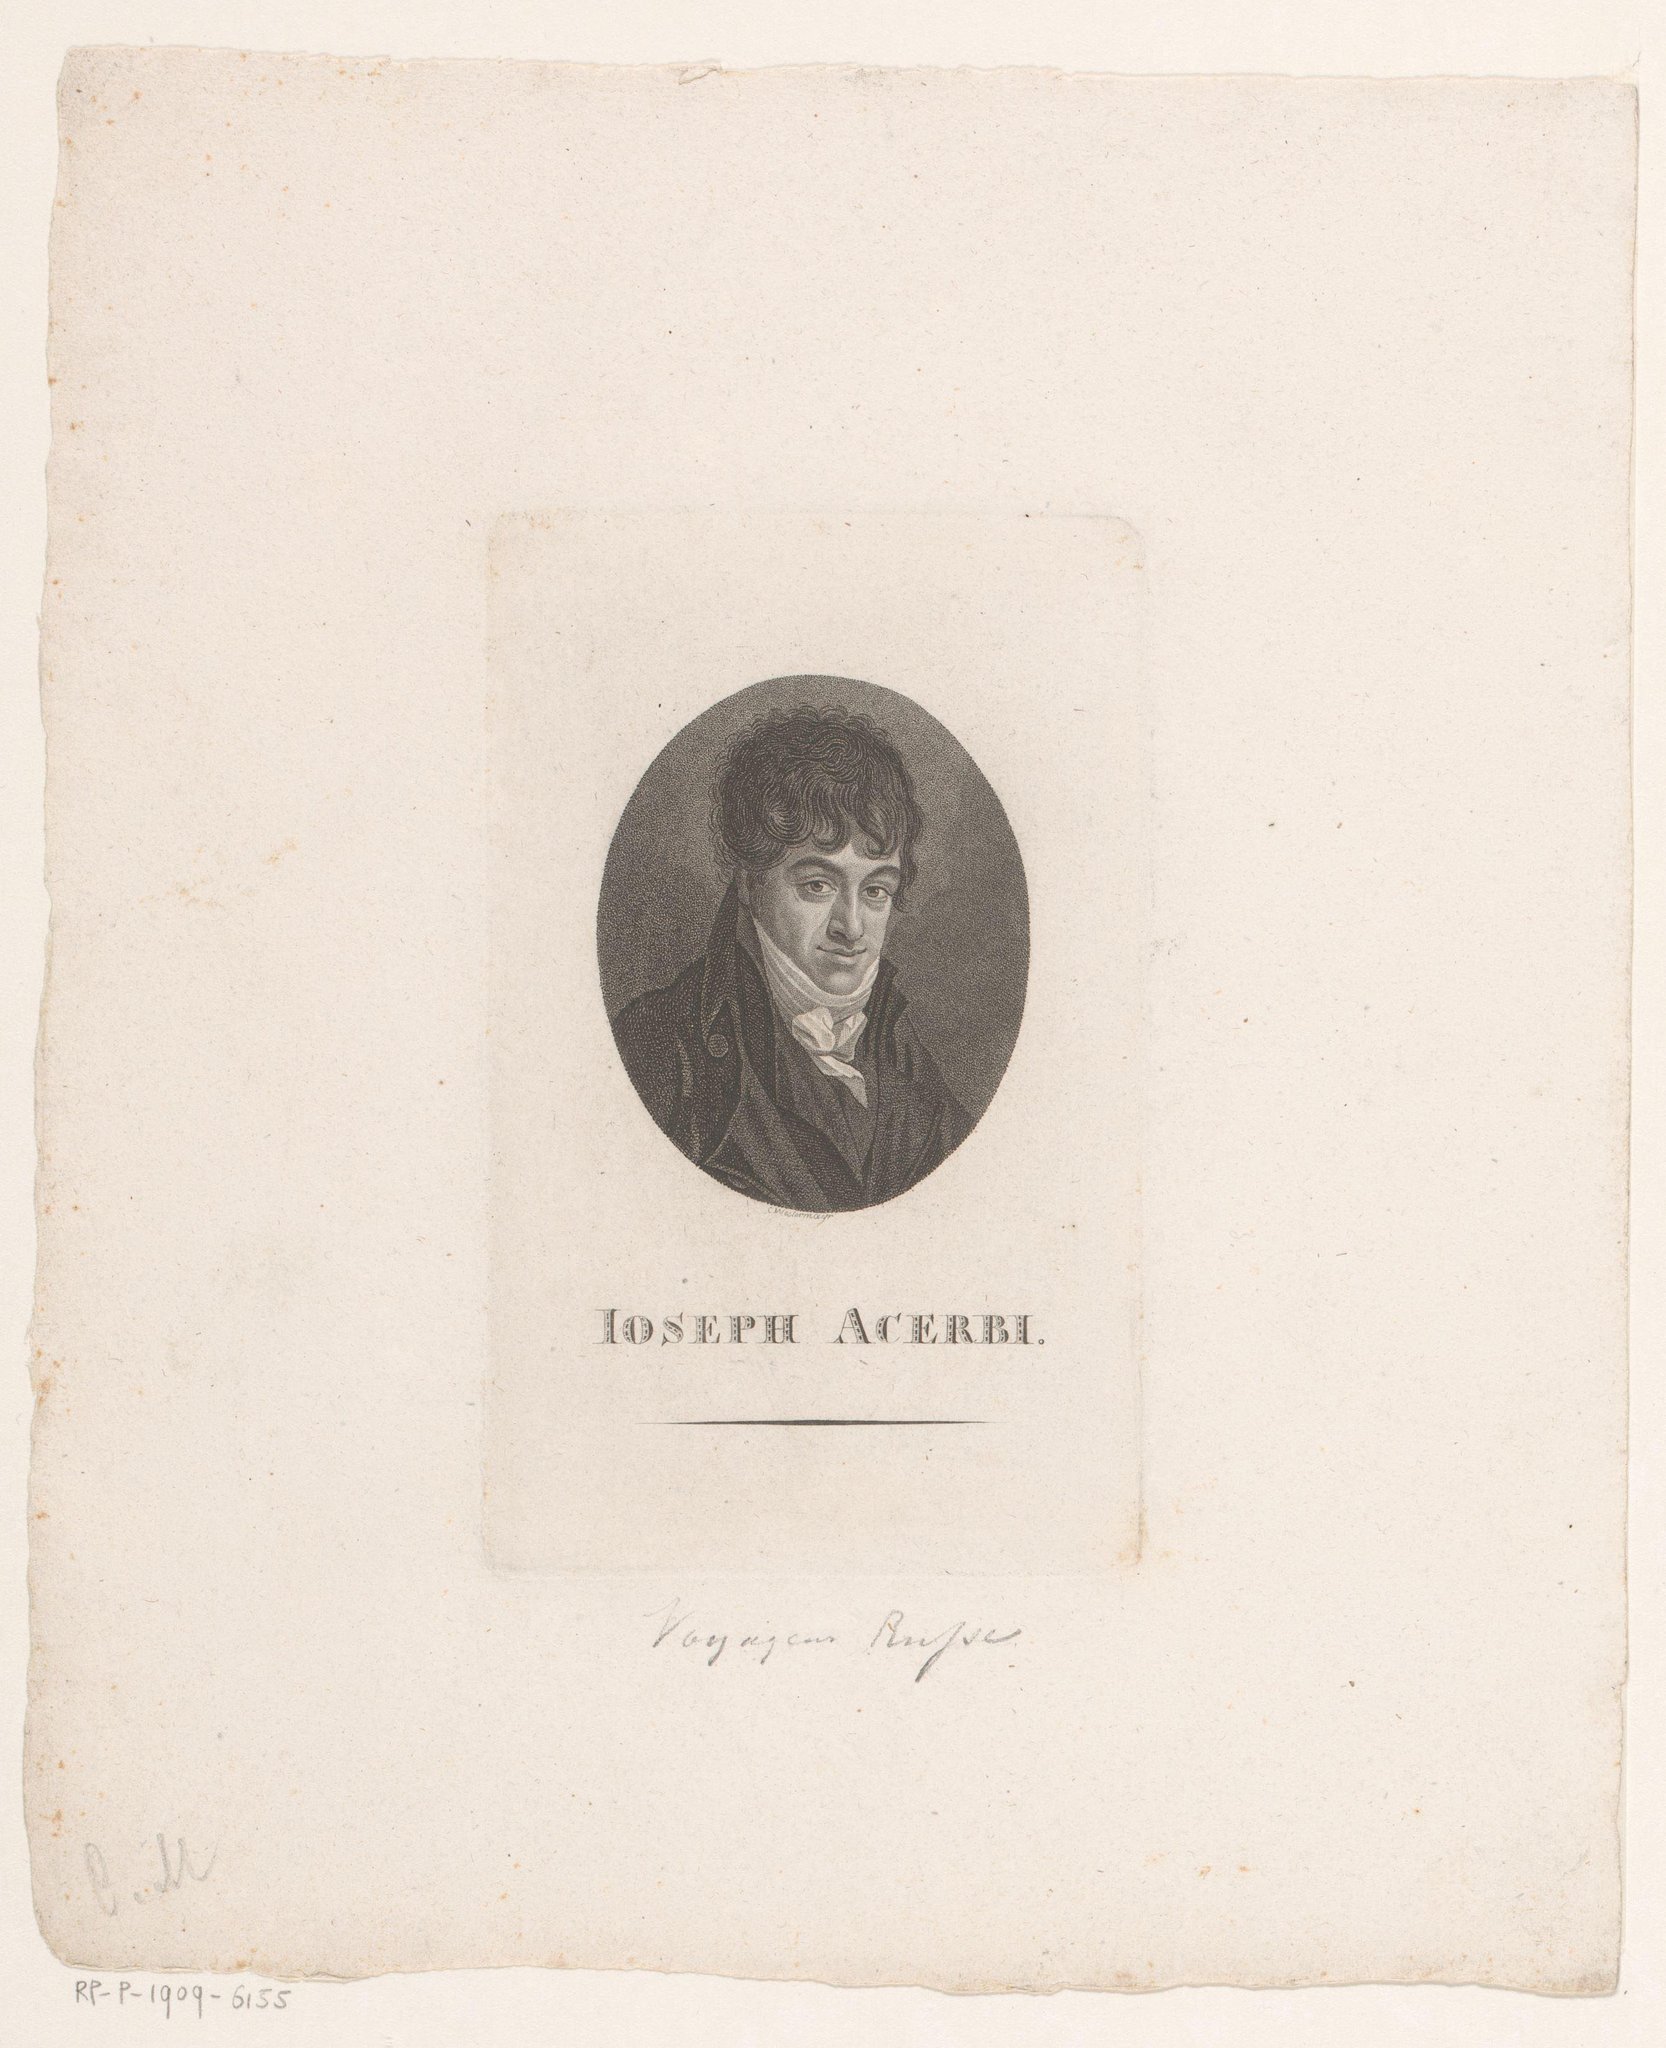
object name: print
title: Portret van Giuseppe Acerbi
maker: konrad westermayr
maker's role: print maker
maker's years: 1765-1834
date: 1775-1834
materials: paper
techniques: engraving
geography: germany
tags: historical persons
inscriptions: collector's mark: Lugt 2228